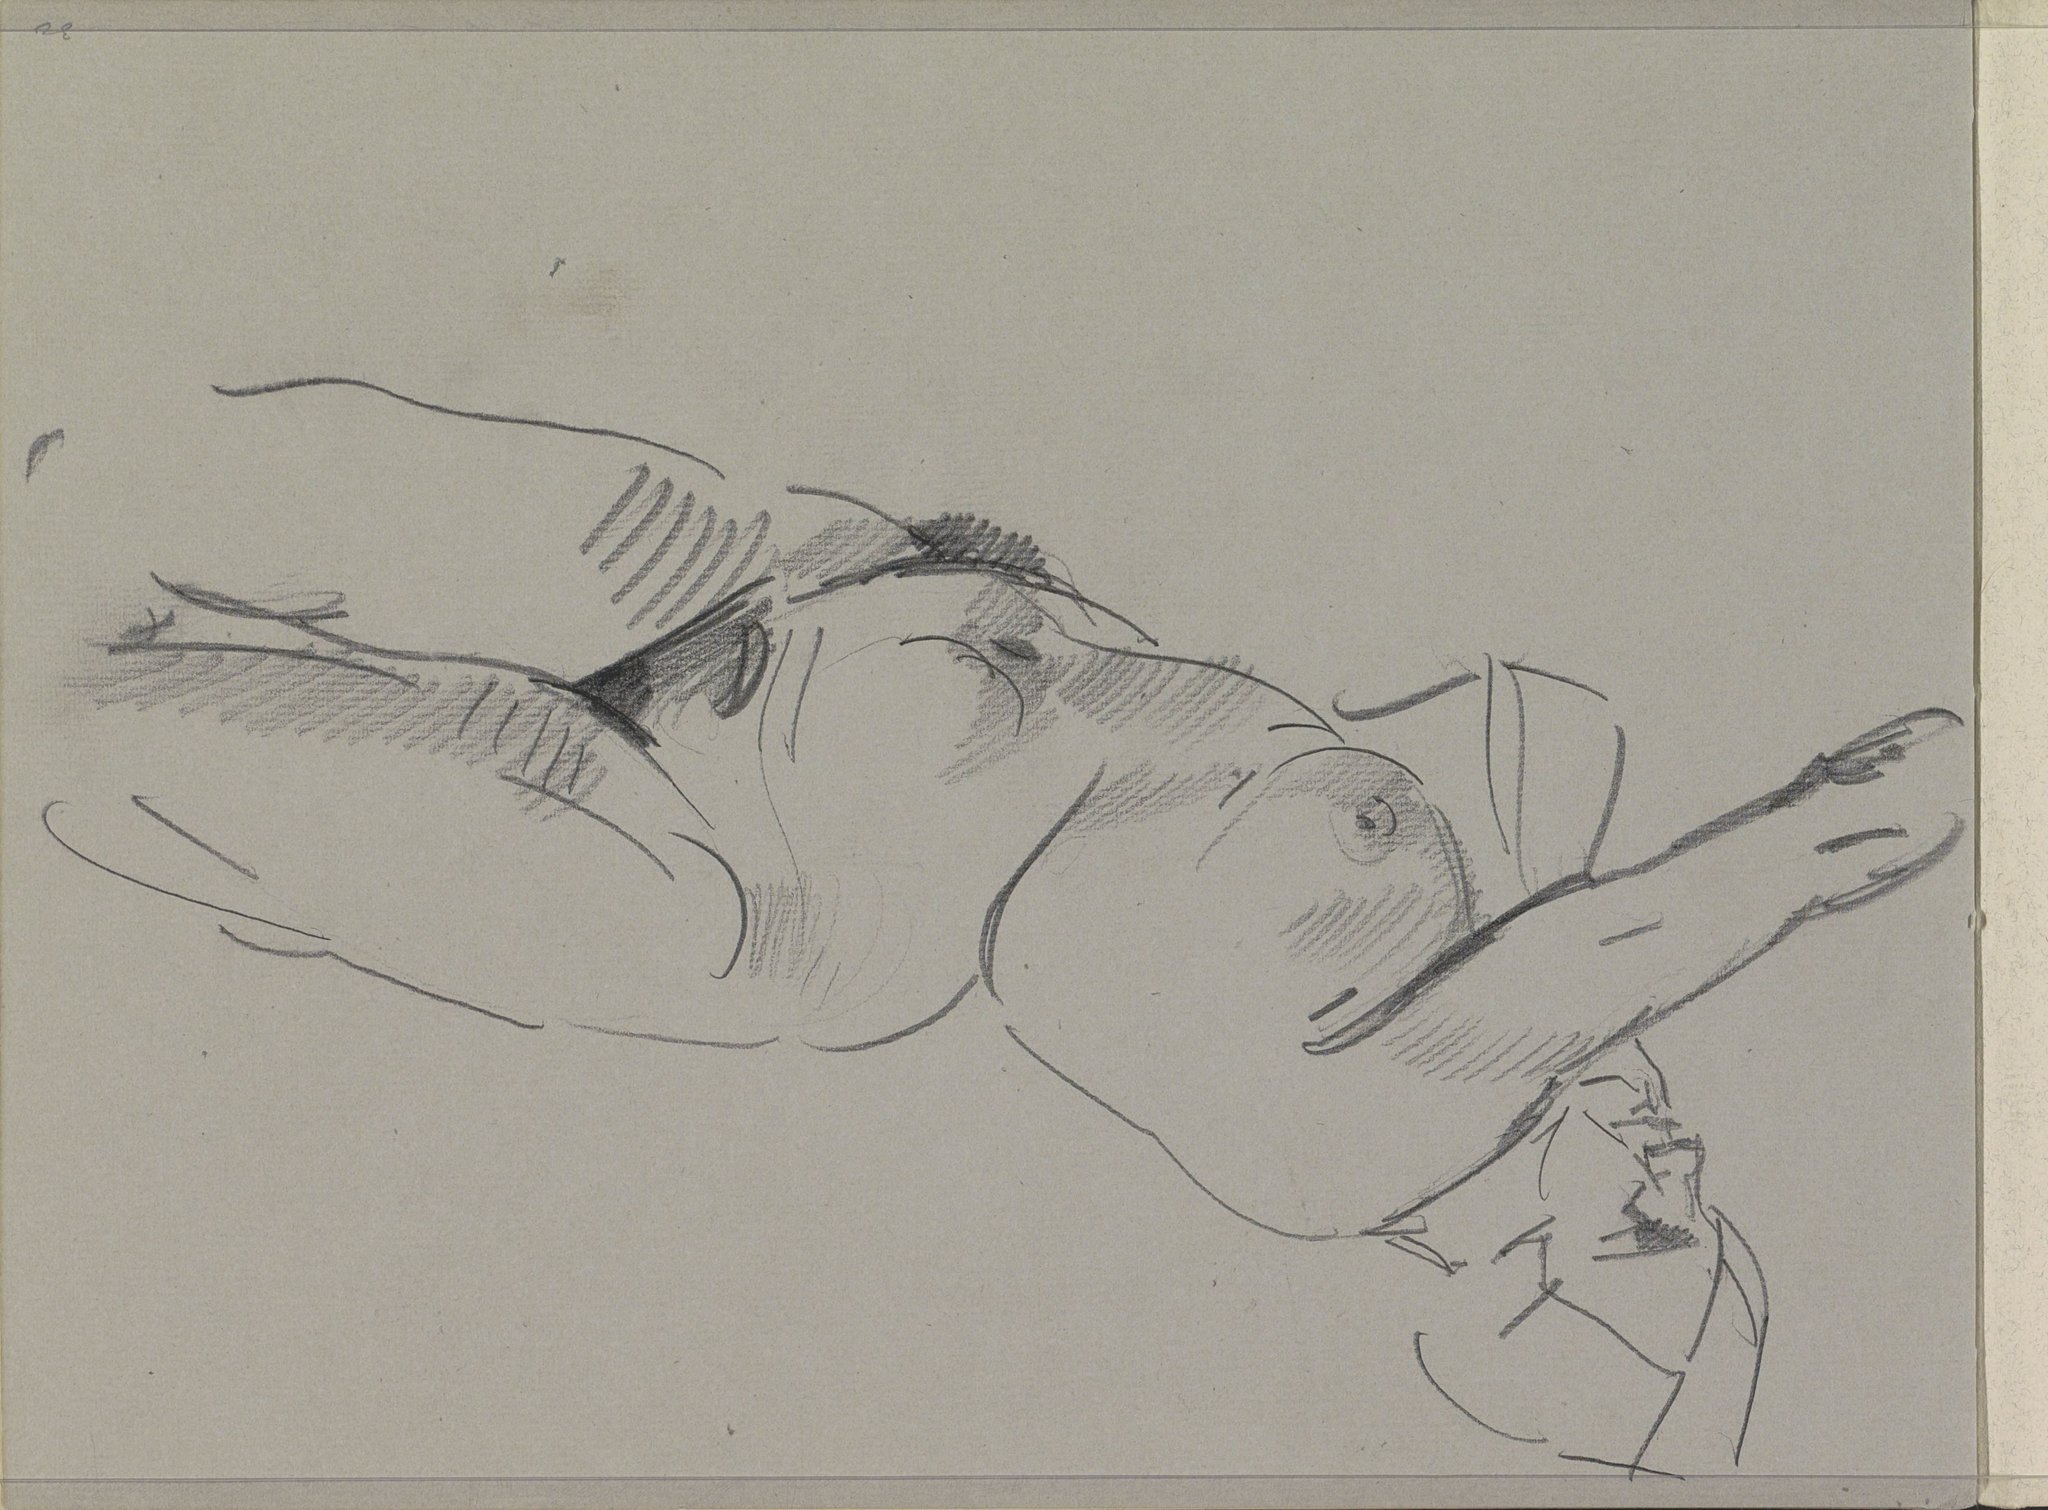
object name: sketchbook leaf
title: Reclining Female Nude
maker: isaac israels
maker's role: draughtsman, painter, print maker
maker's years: 1865-1934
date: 1875-1934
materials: paper, pencil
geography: the hague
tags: lying figure - aa - female human figure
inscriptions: watermark: ‘VGZ’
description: Ze steunt op haar elleboog. Blad 25 verso uit schetsboek IV met 27 bladen.